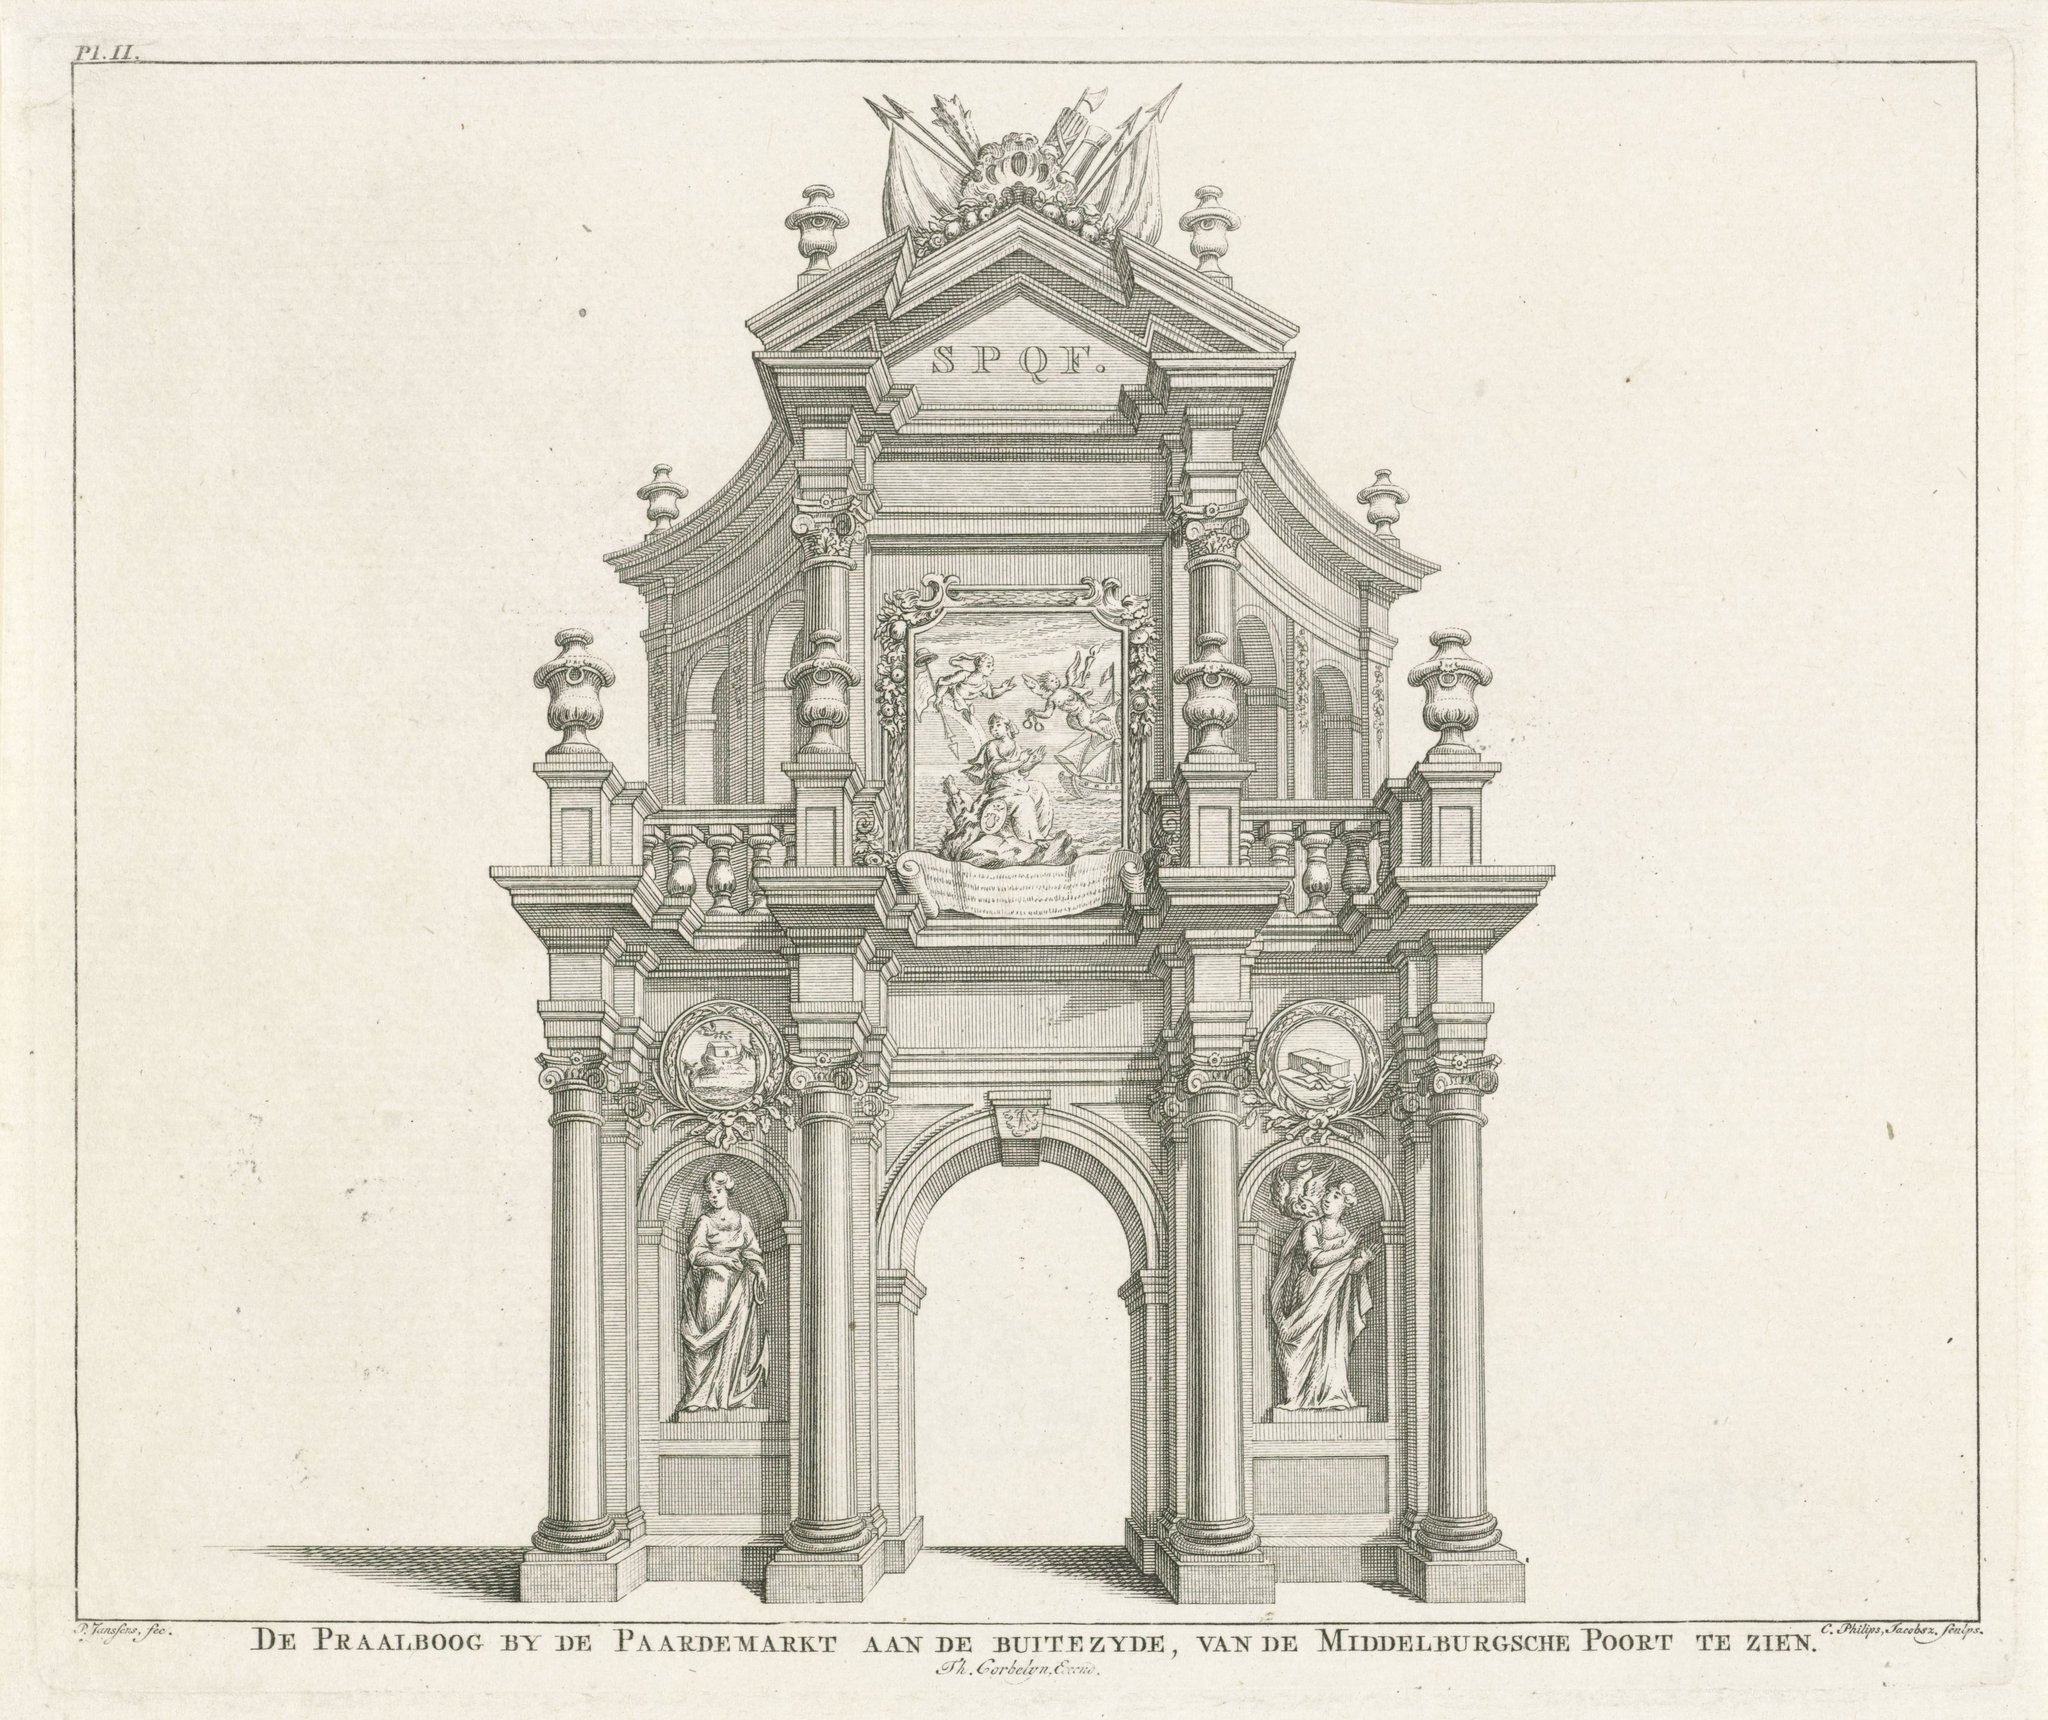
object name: print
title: Praalboog bij de Paardenmarkt te Vlissingen, 1772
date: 1772-1773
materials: paper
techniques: engraving, etching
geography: flushing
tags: triumphal arch, flushing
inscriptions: collector's mark: Lugt 2228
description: Buitenzijde van de ereboog opgericht op de Paardenmarkt te Vlissingen, bij de viering van 200 jaar vrijheid in Vlissingen, 6 april 1772. Genummerd linksboven: Pl. II. Onderdeel van een groep van negen platen genummerd I-X van de decoraties bij dit feest.